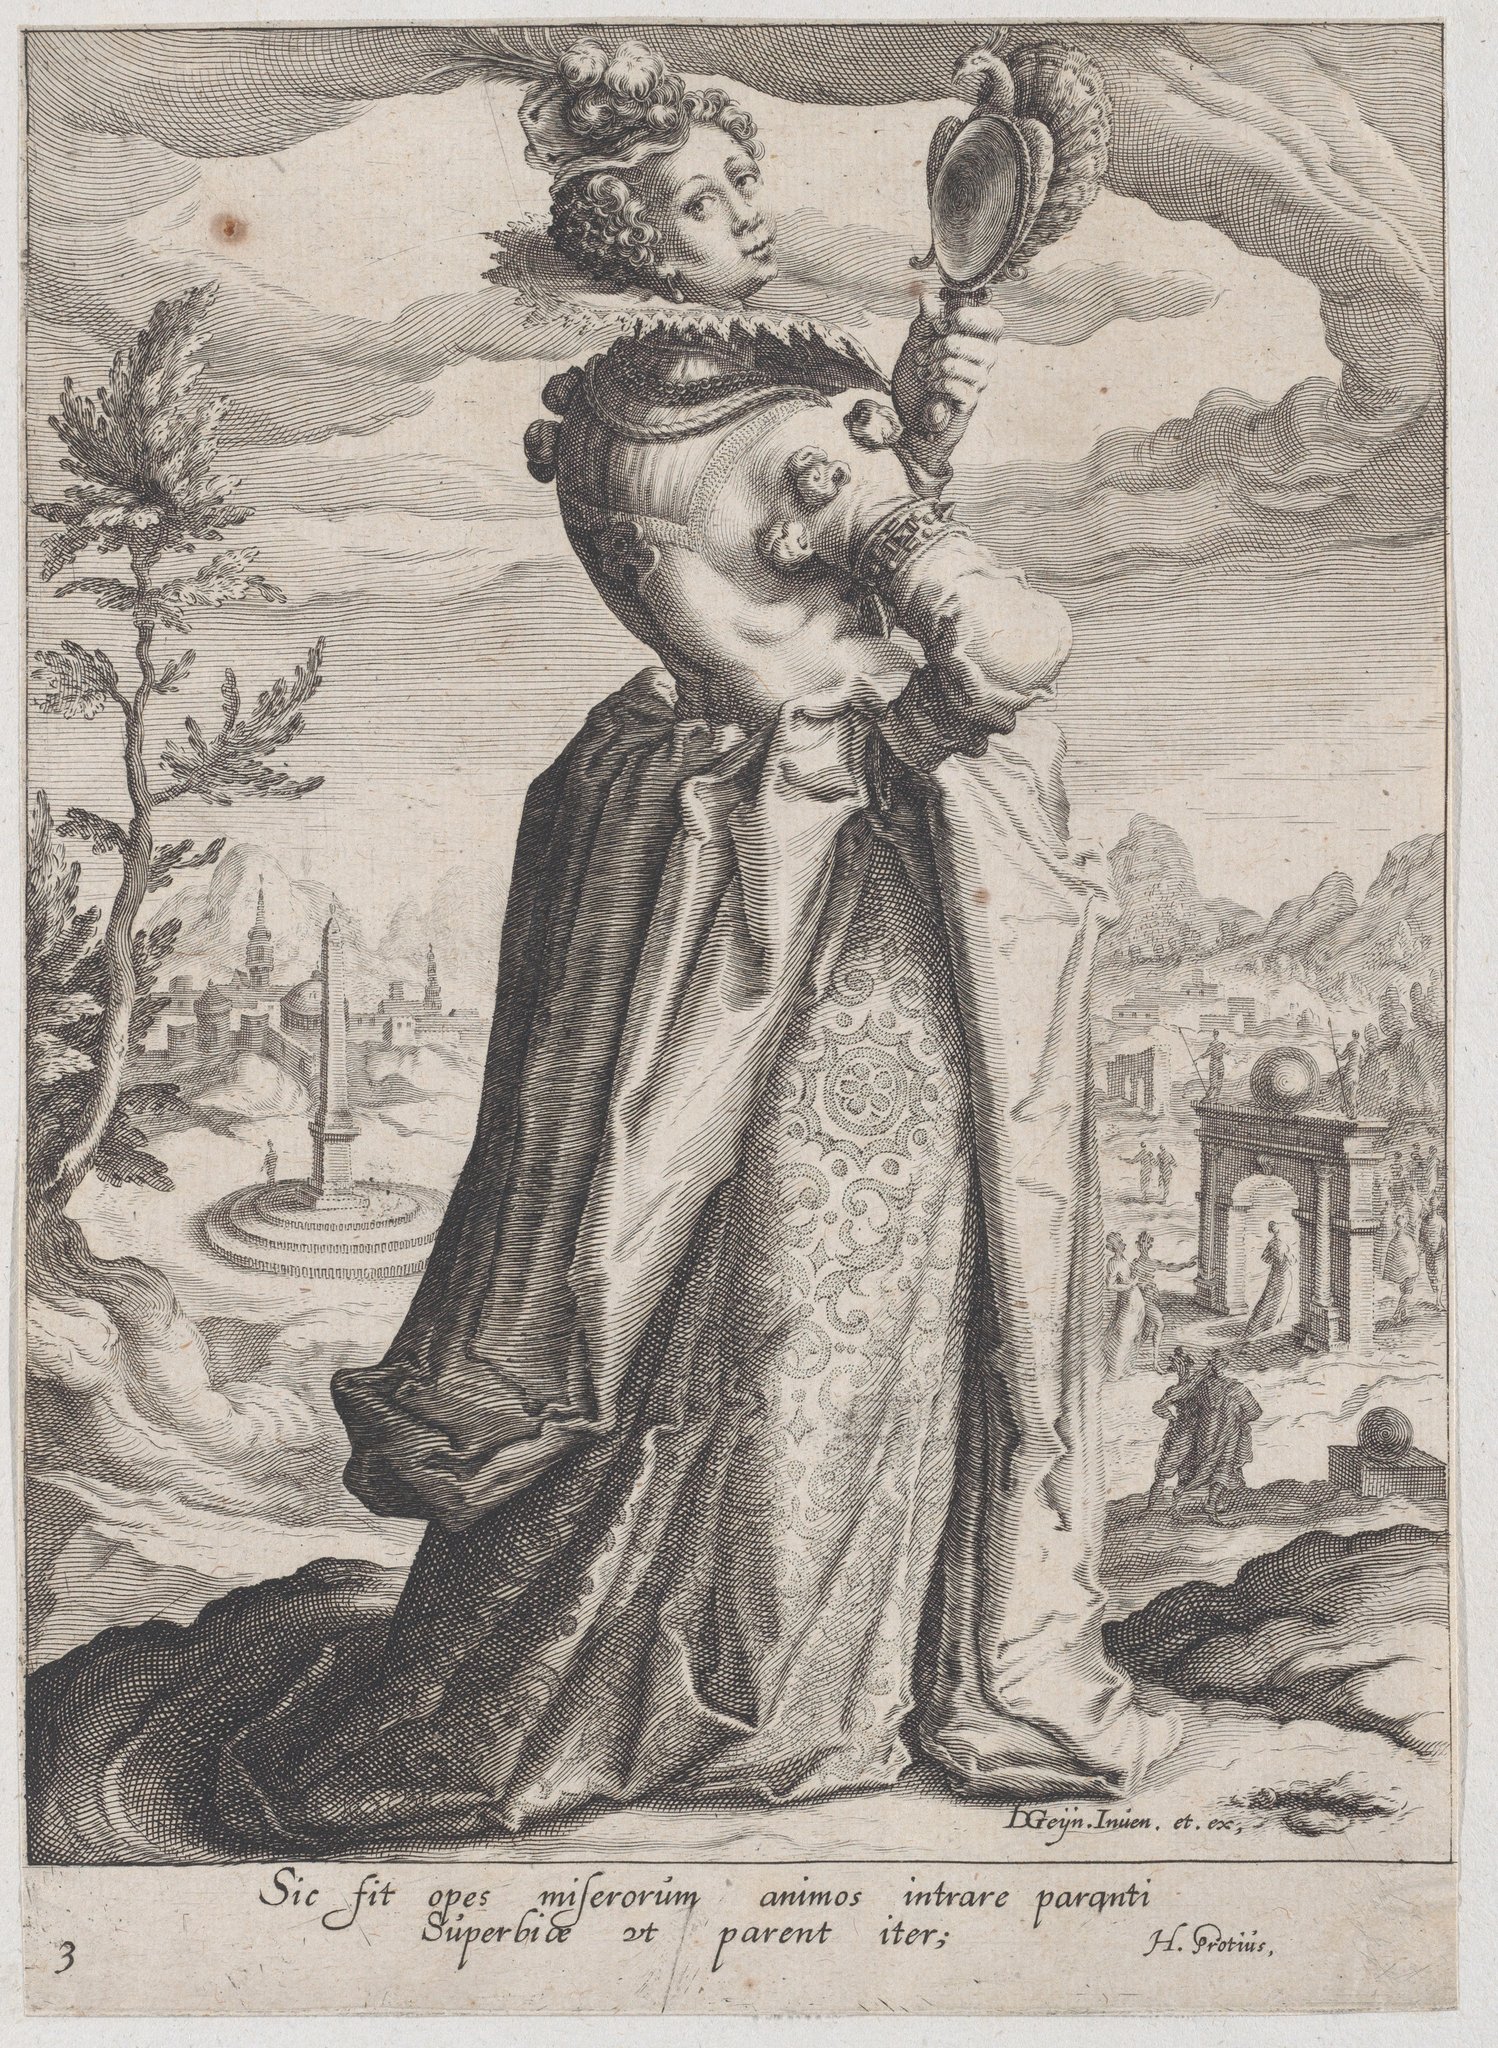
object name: print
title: Pride, from "Virtues and Vices"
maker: zacharias dolendo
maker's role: artist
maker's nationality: netherlandish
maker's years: 1561-1604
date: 1596-1597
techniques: engraving